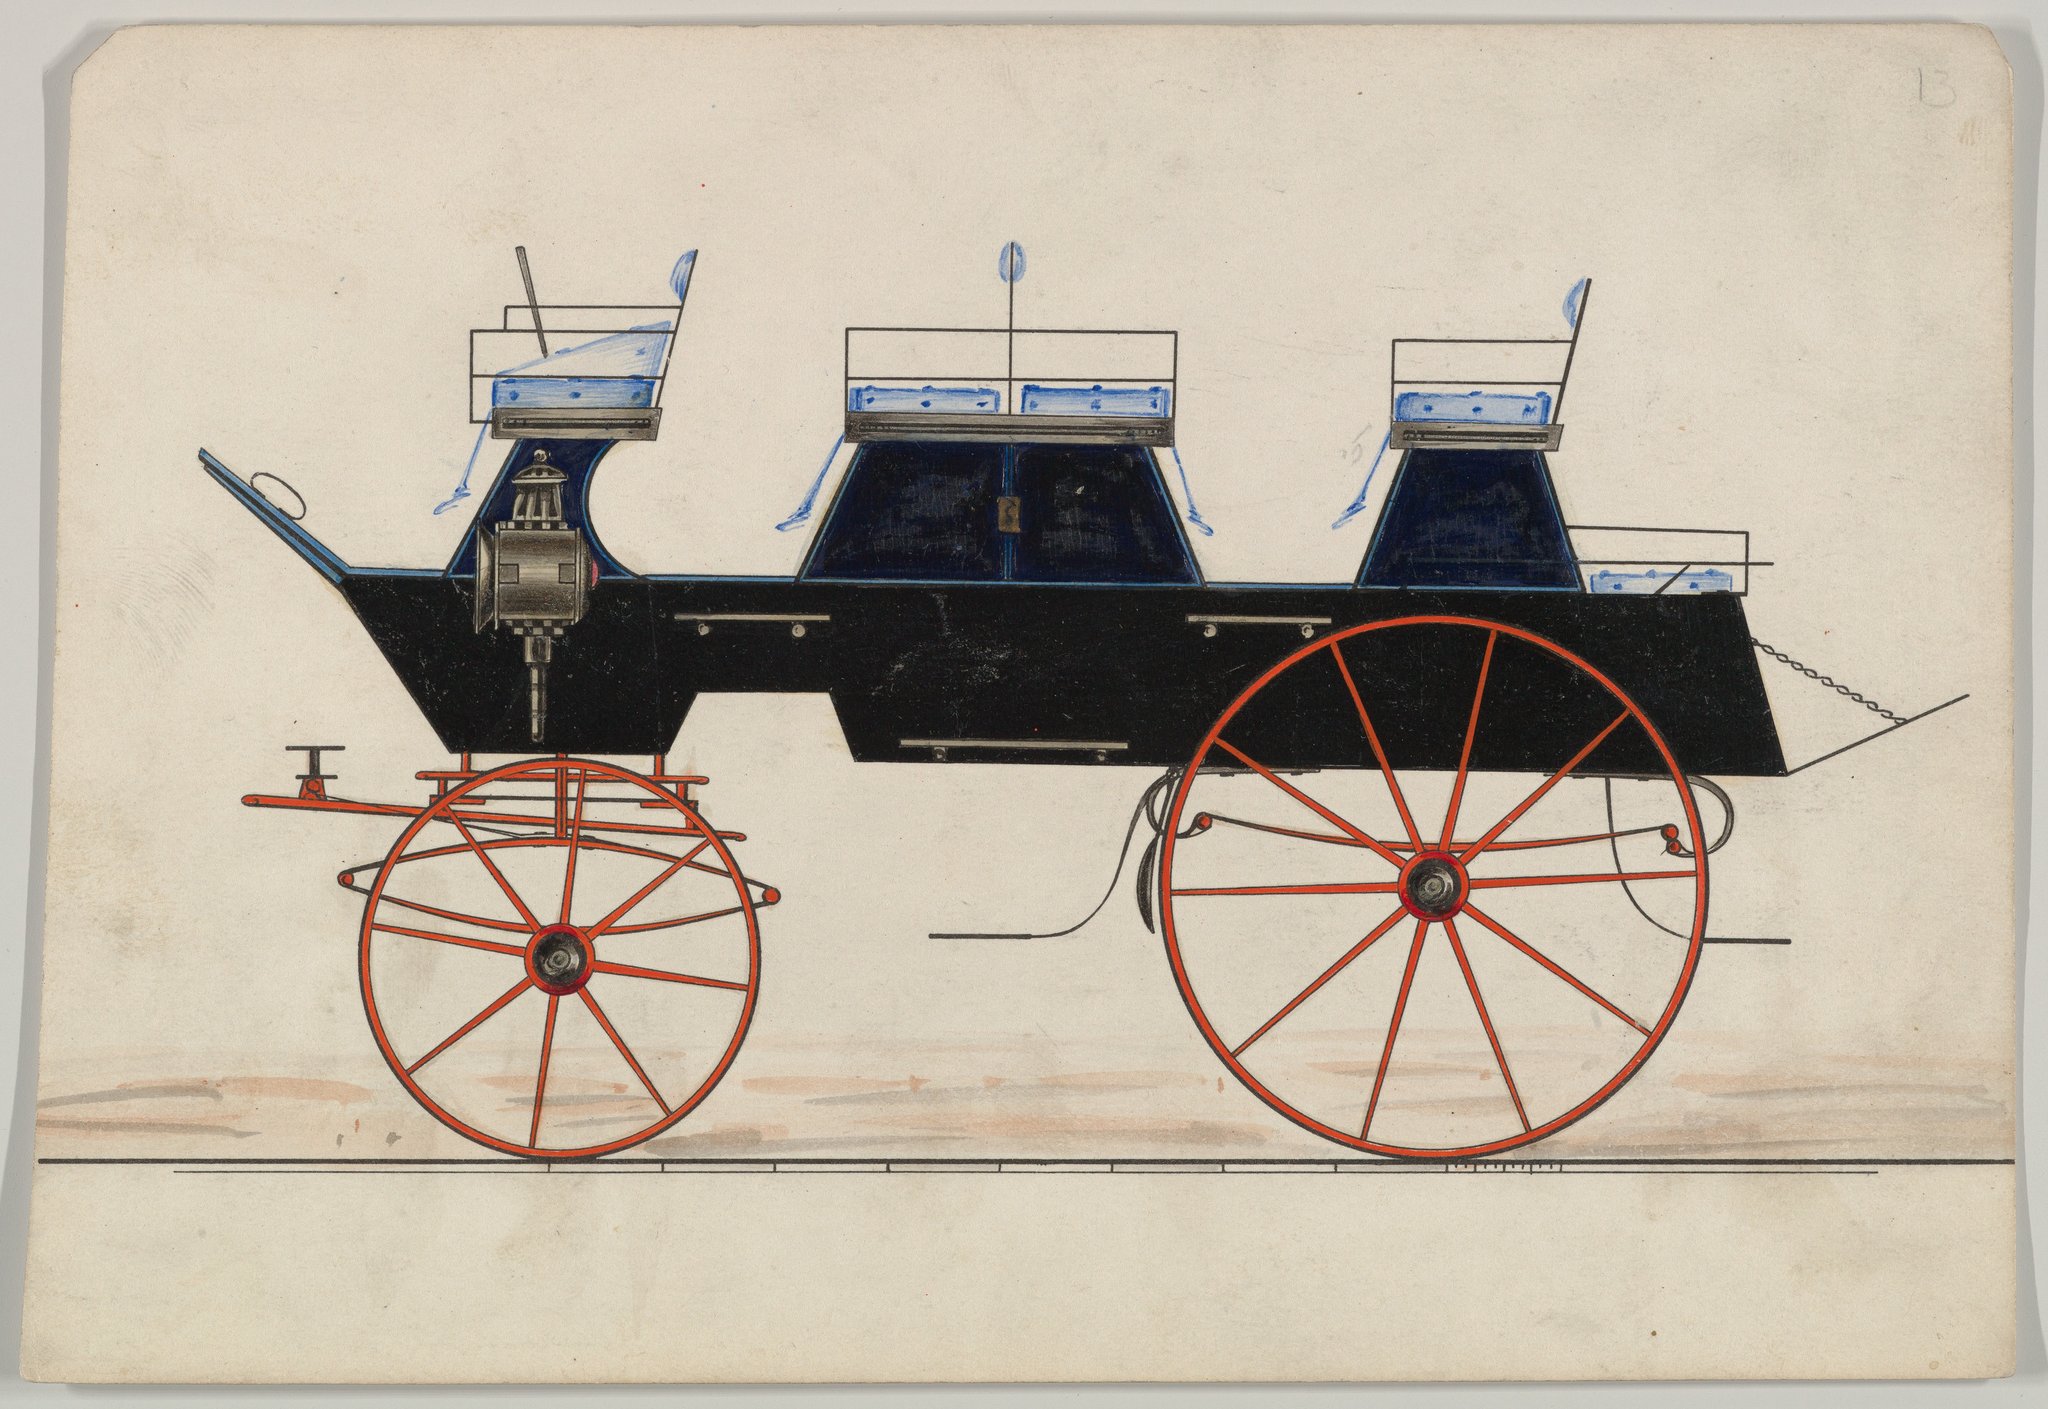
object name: drawing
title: Design for a Break (no number)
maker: brewster & co.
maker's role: manufacturer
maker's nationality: american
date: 1850-1870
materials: gouache, gum arabic, ink, watercolor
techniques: pen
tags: carriages